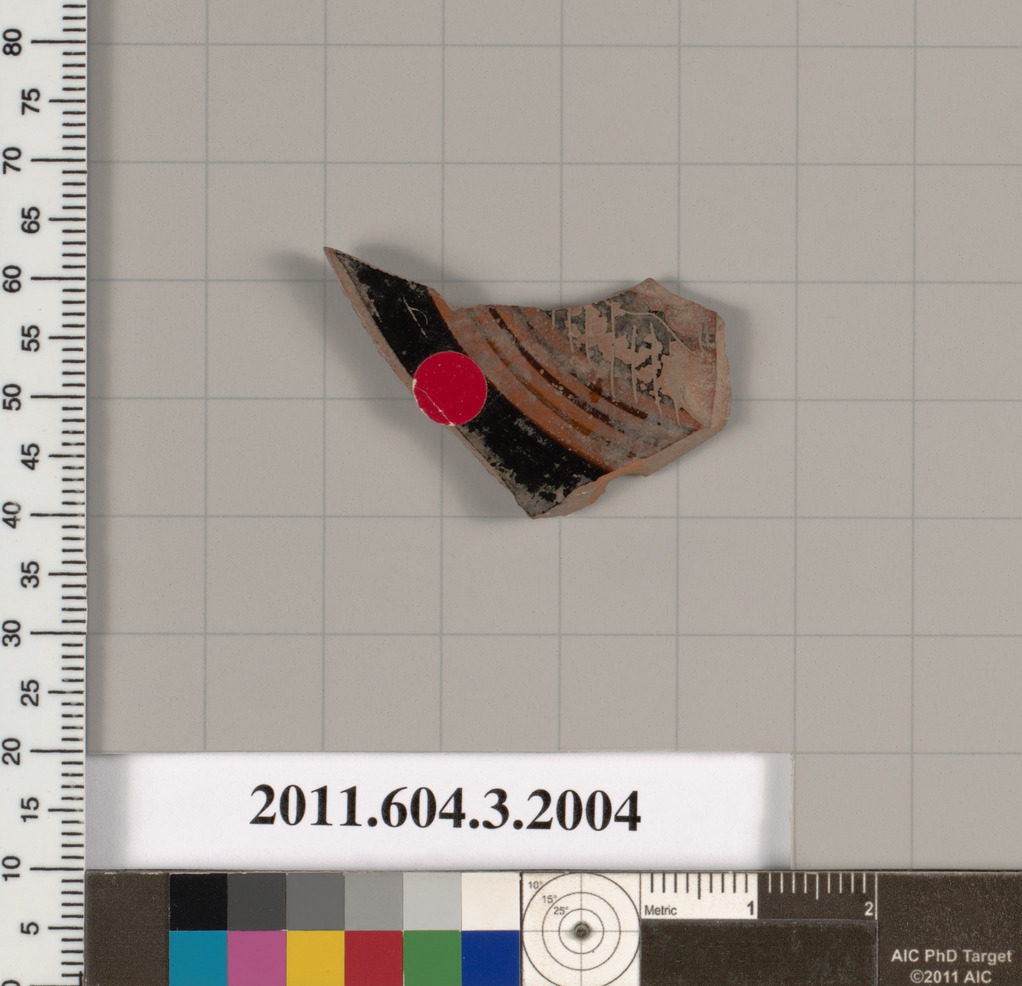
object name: kylix fragment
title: Terracotta fragment of a kylix (drinking cup)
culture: greek, attic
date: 550-526 BCE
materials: terracotta